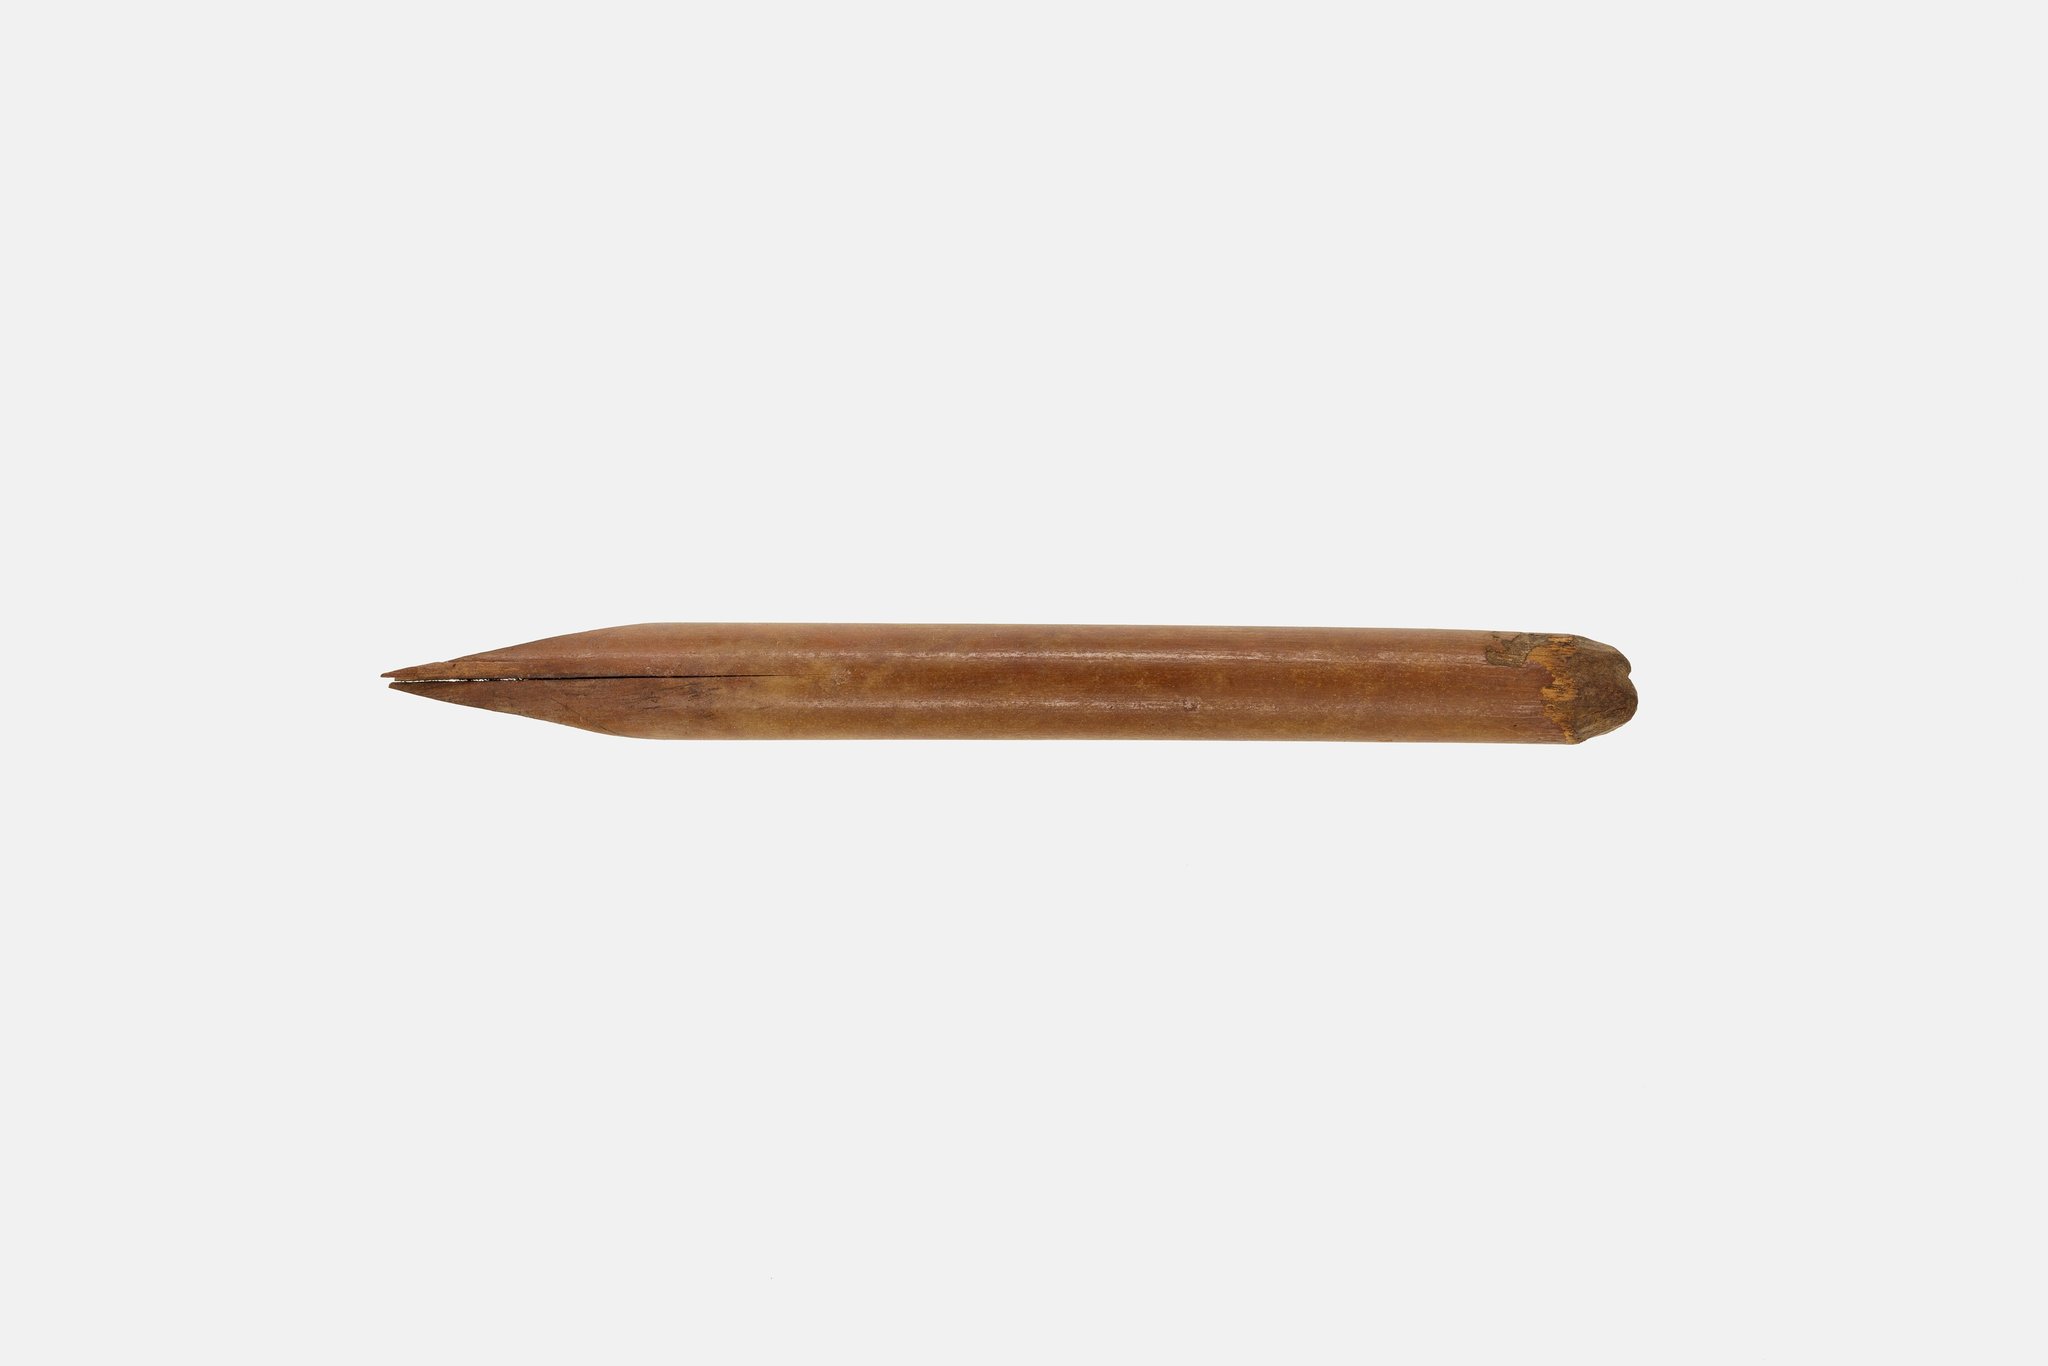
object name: pen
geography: egypt